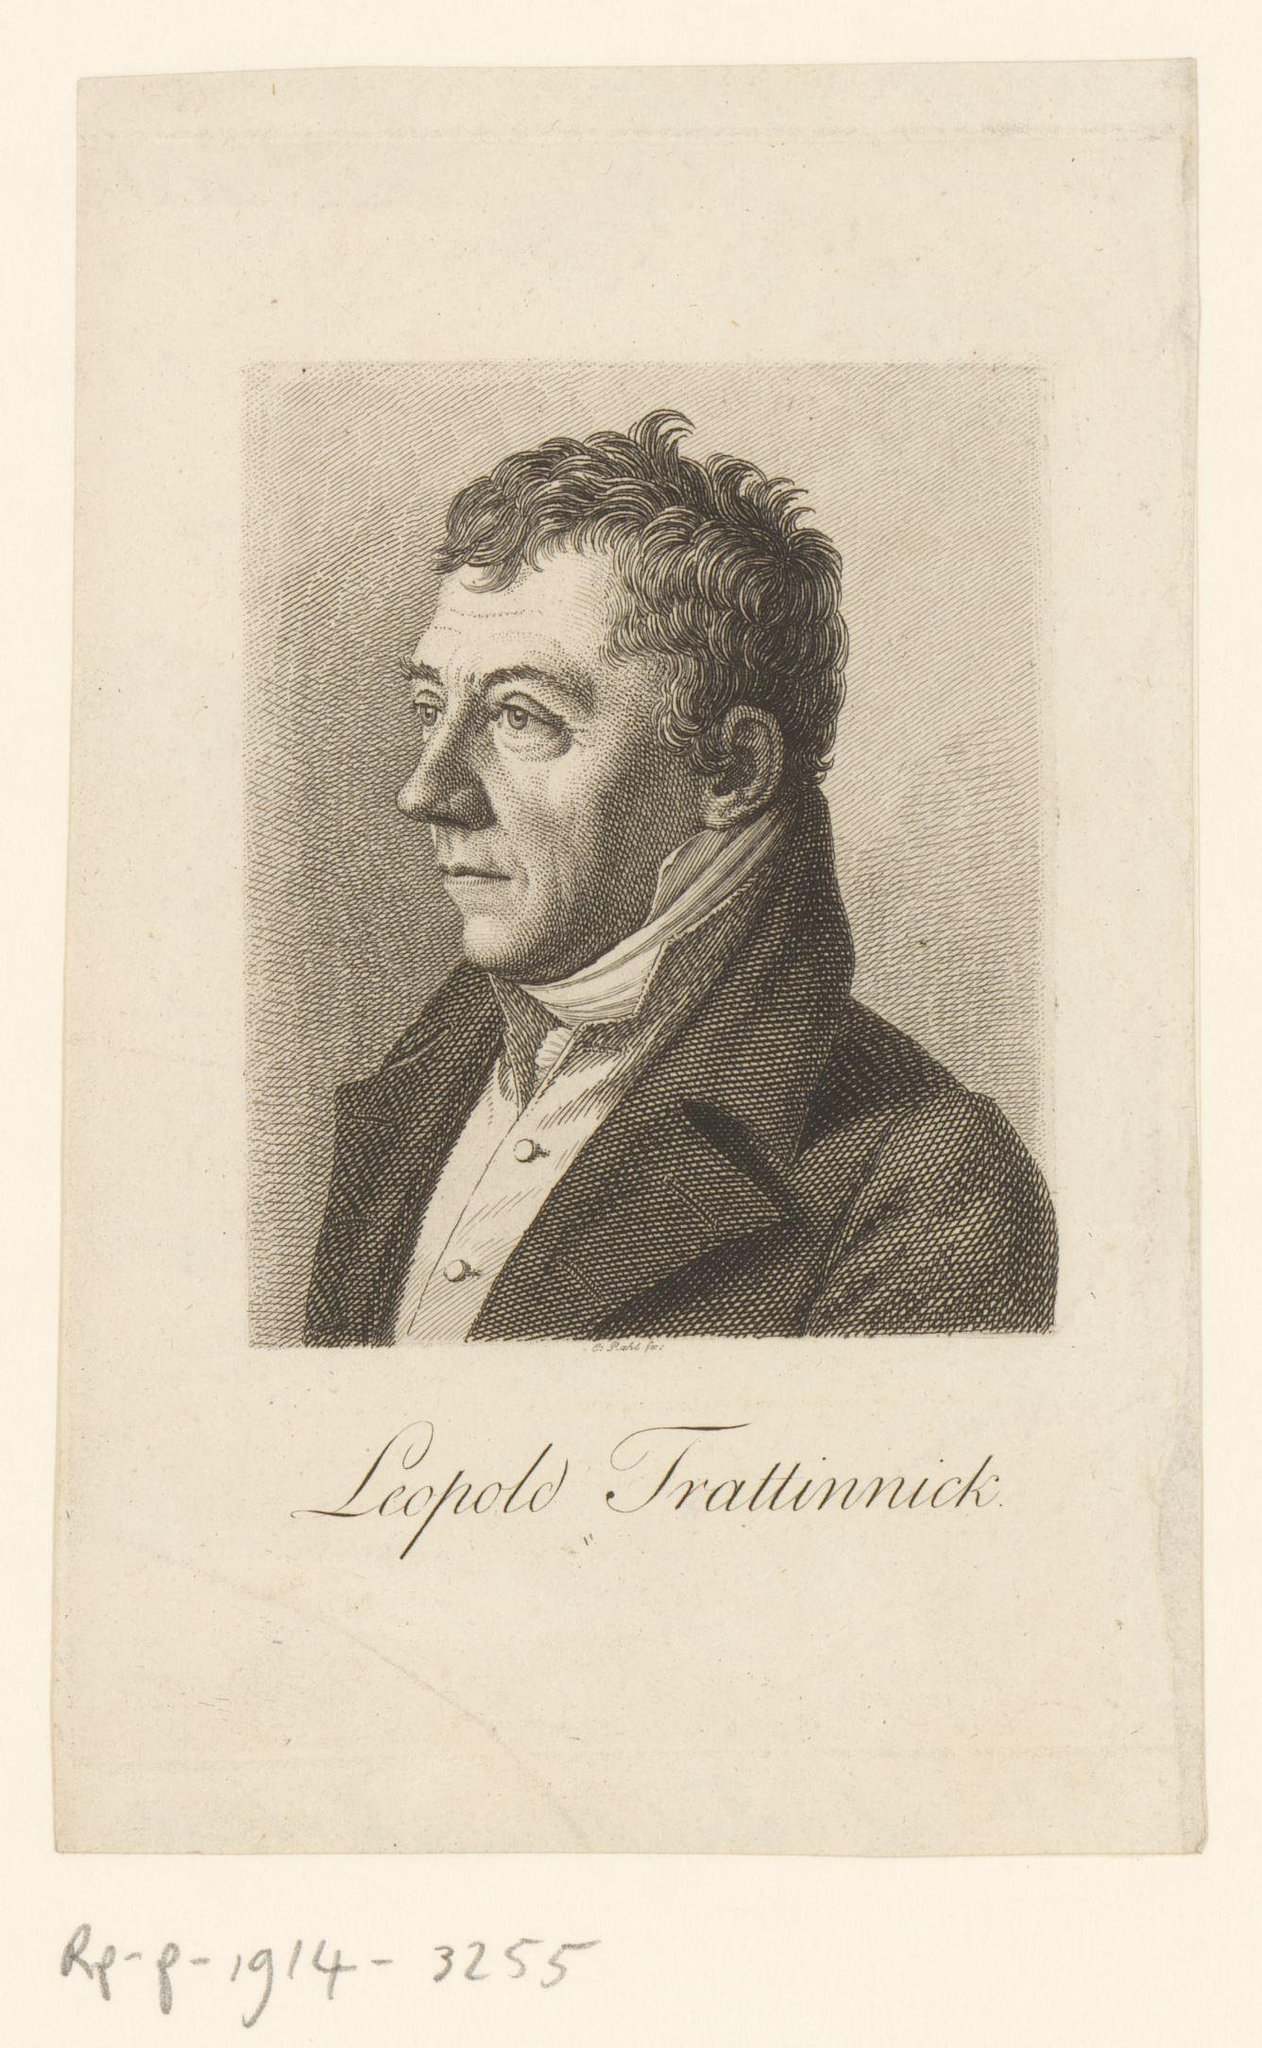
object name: print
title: Portret van Leopold Trattinnick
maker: carl heinrich rahl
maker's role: painter, print maker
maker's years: 1779-1843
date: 1789-1843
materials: paper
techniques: etching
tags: vienna, historical persons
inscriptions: collector's mark: Lugt 2228